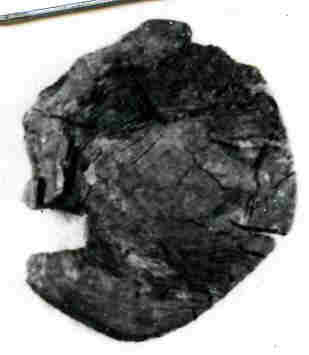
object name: coin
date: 401-1400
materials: copper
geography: iran